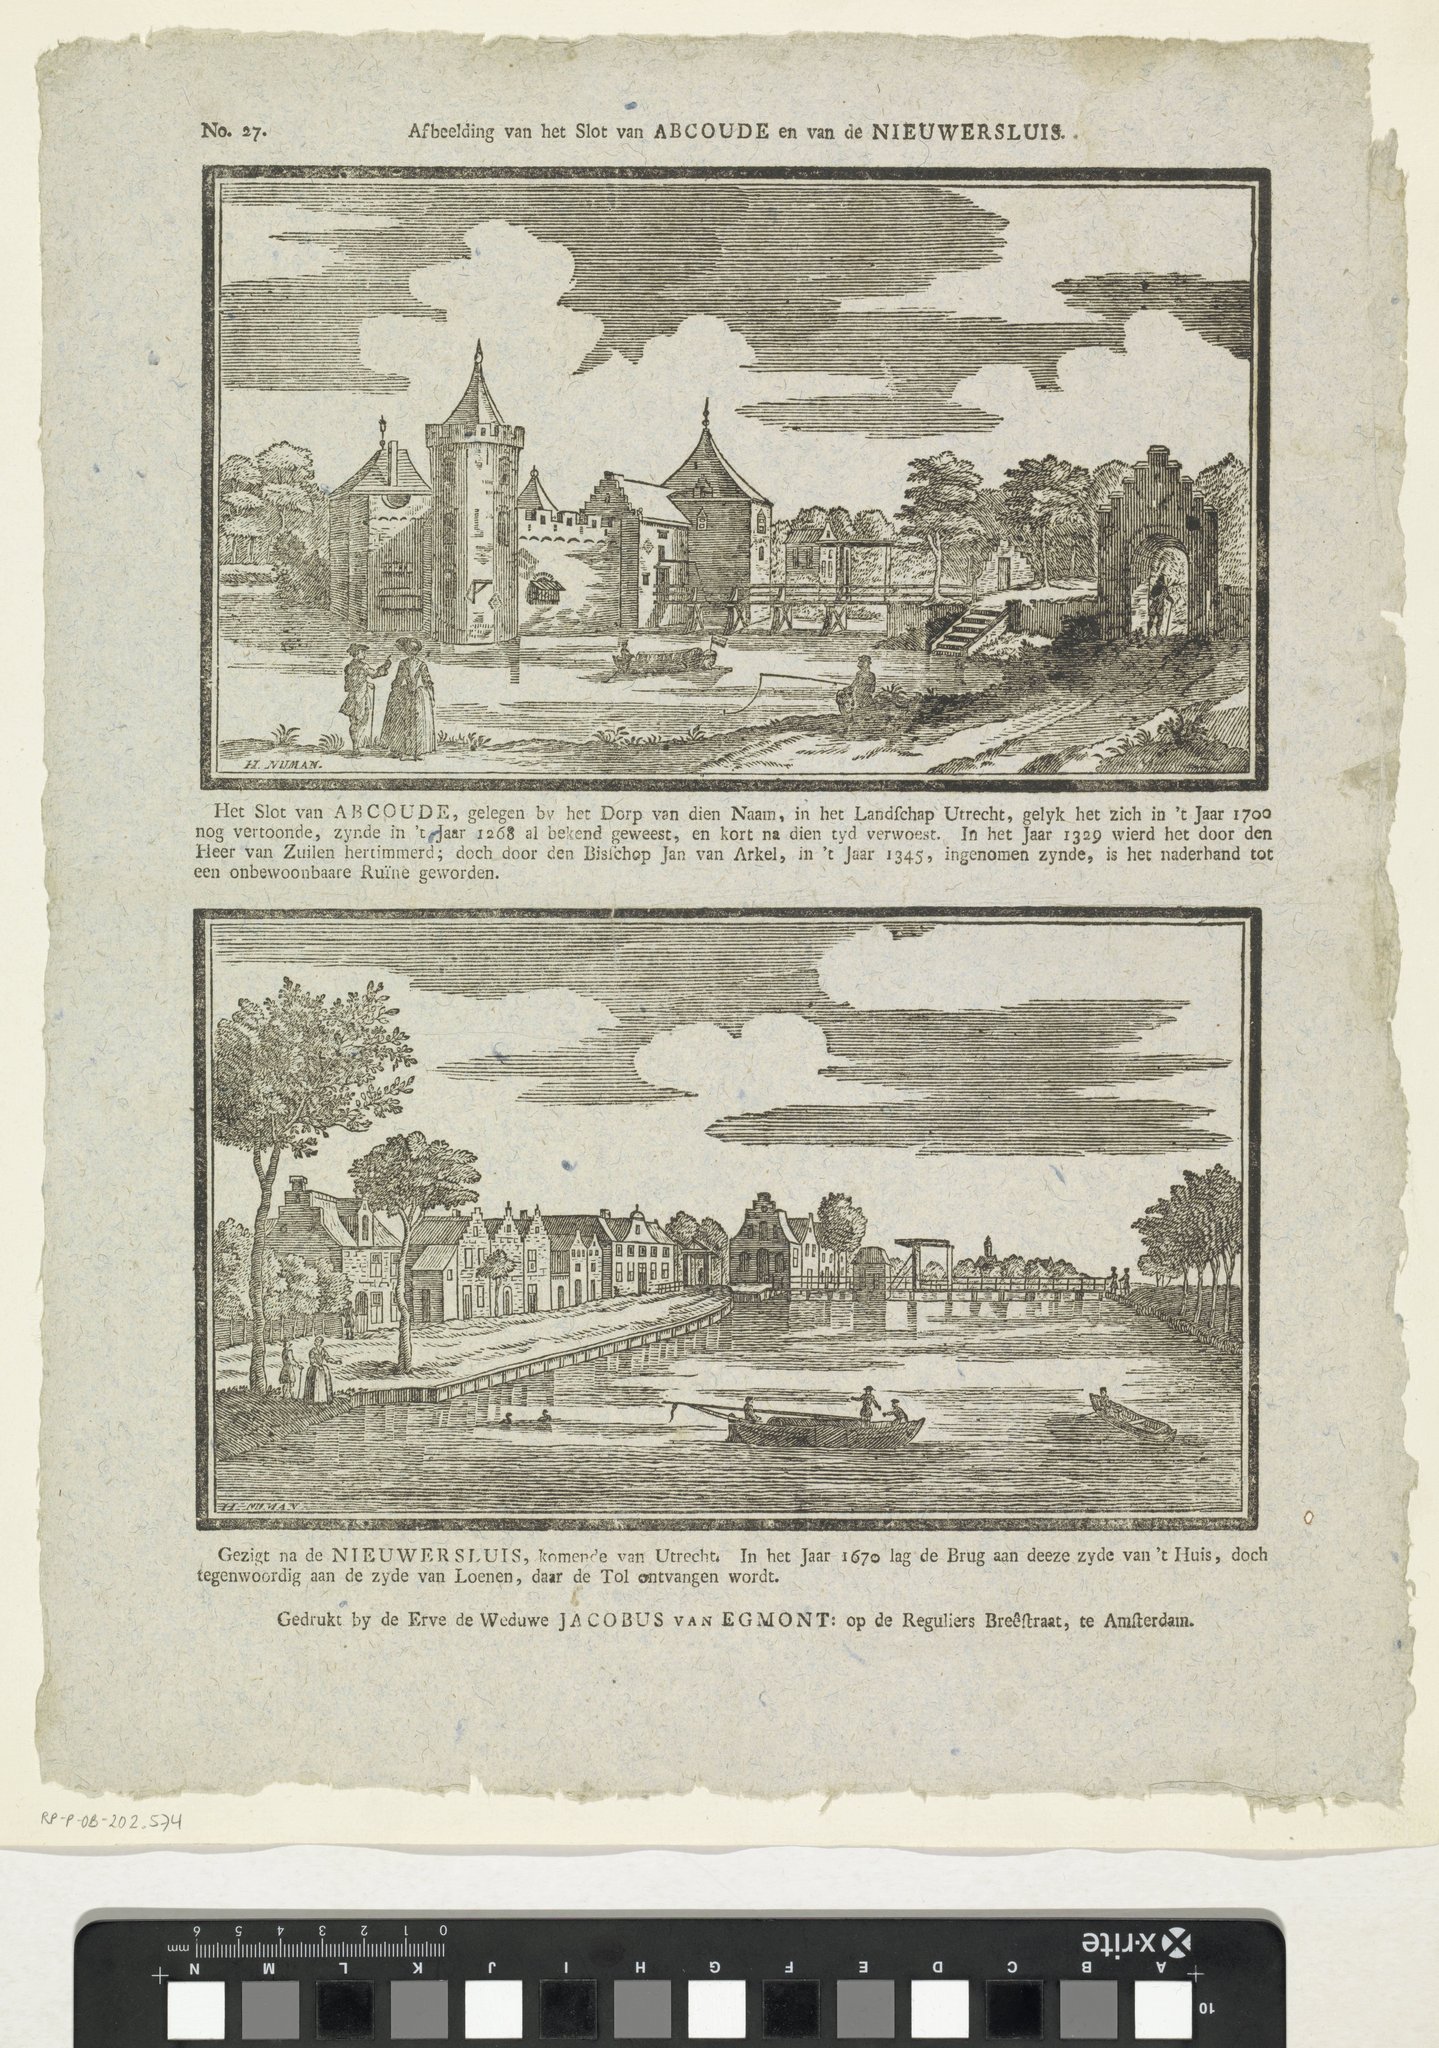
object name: popular print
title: Afbeelding van het Slot van Abcoude en van de Nieuwersluis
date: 1761-1804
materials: paper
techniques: letterpress printing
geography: amsterdam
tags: city-view, and landscape with man-made constructions, abcoude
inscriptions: collector's mark: Lugt 2760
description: Blad met 2 voorstellingen van het Slot van Abcoude en de Nieuwersluis te Loenen. Onder elke afbeelding een onderschrift. Genummerd linksboven: No. 27.